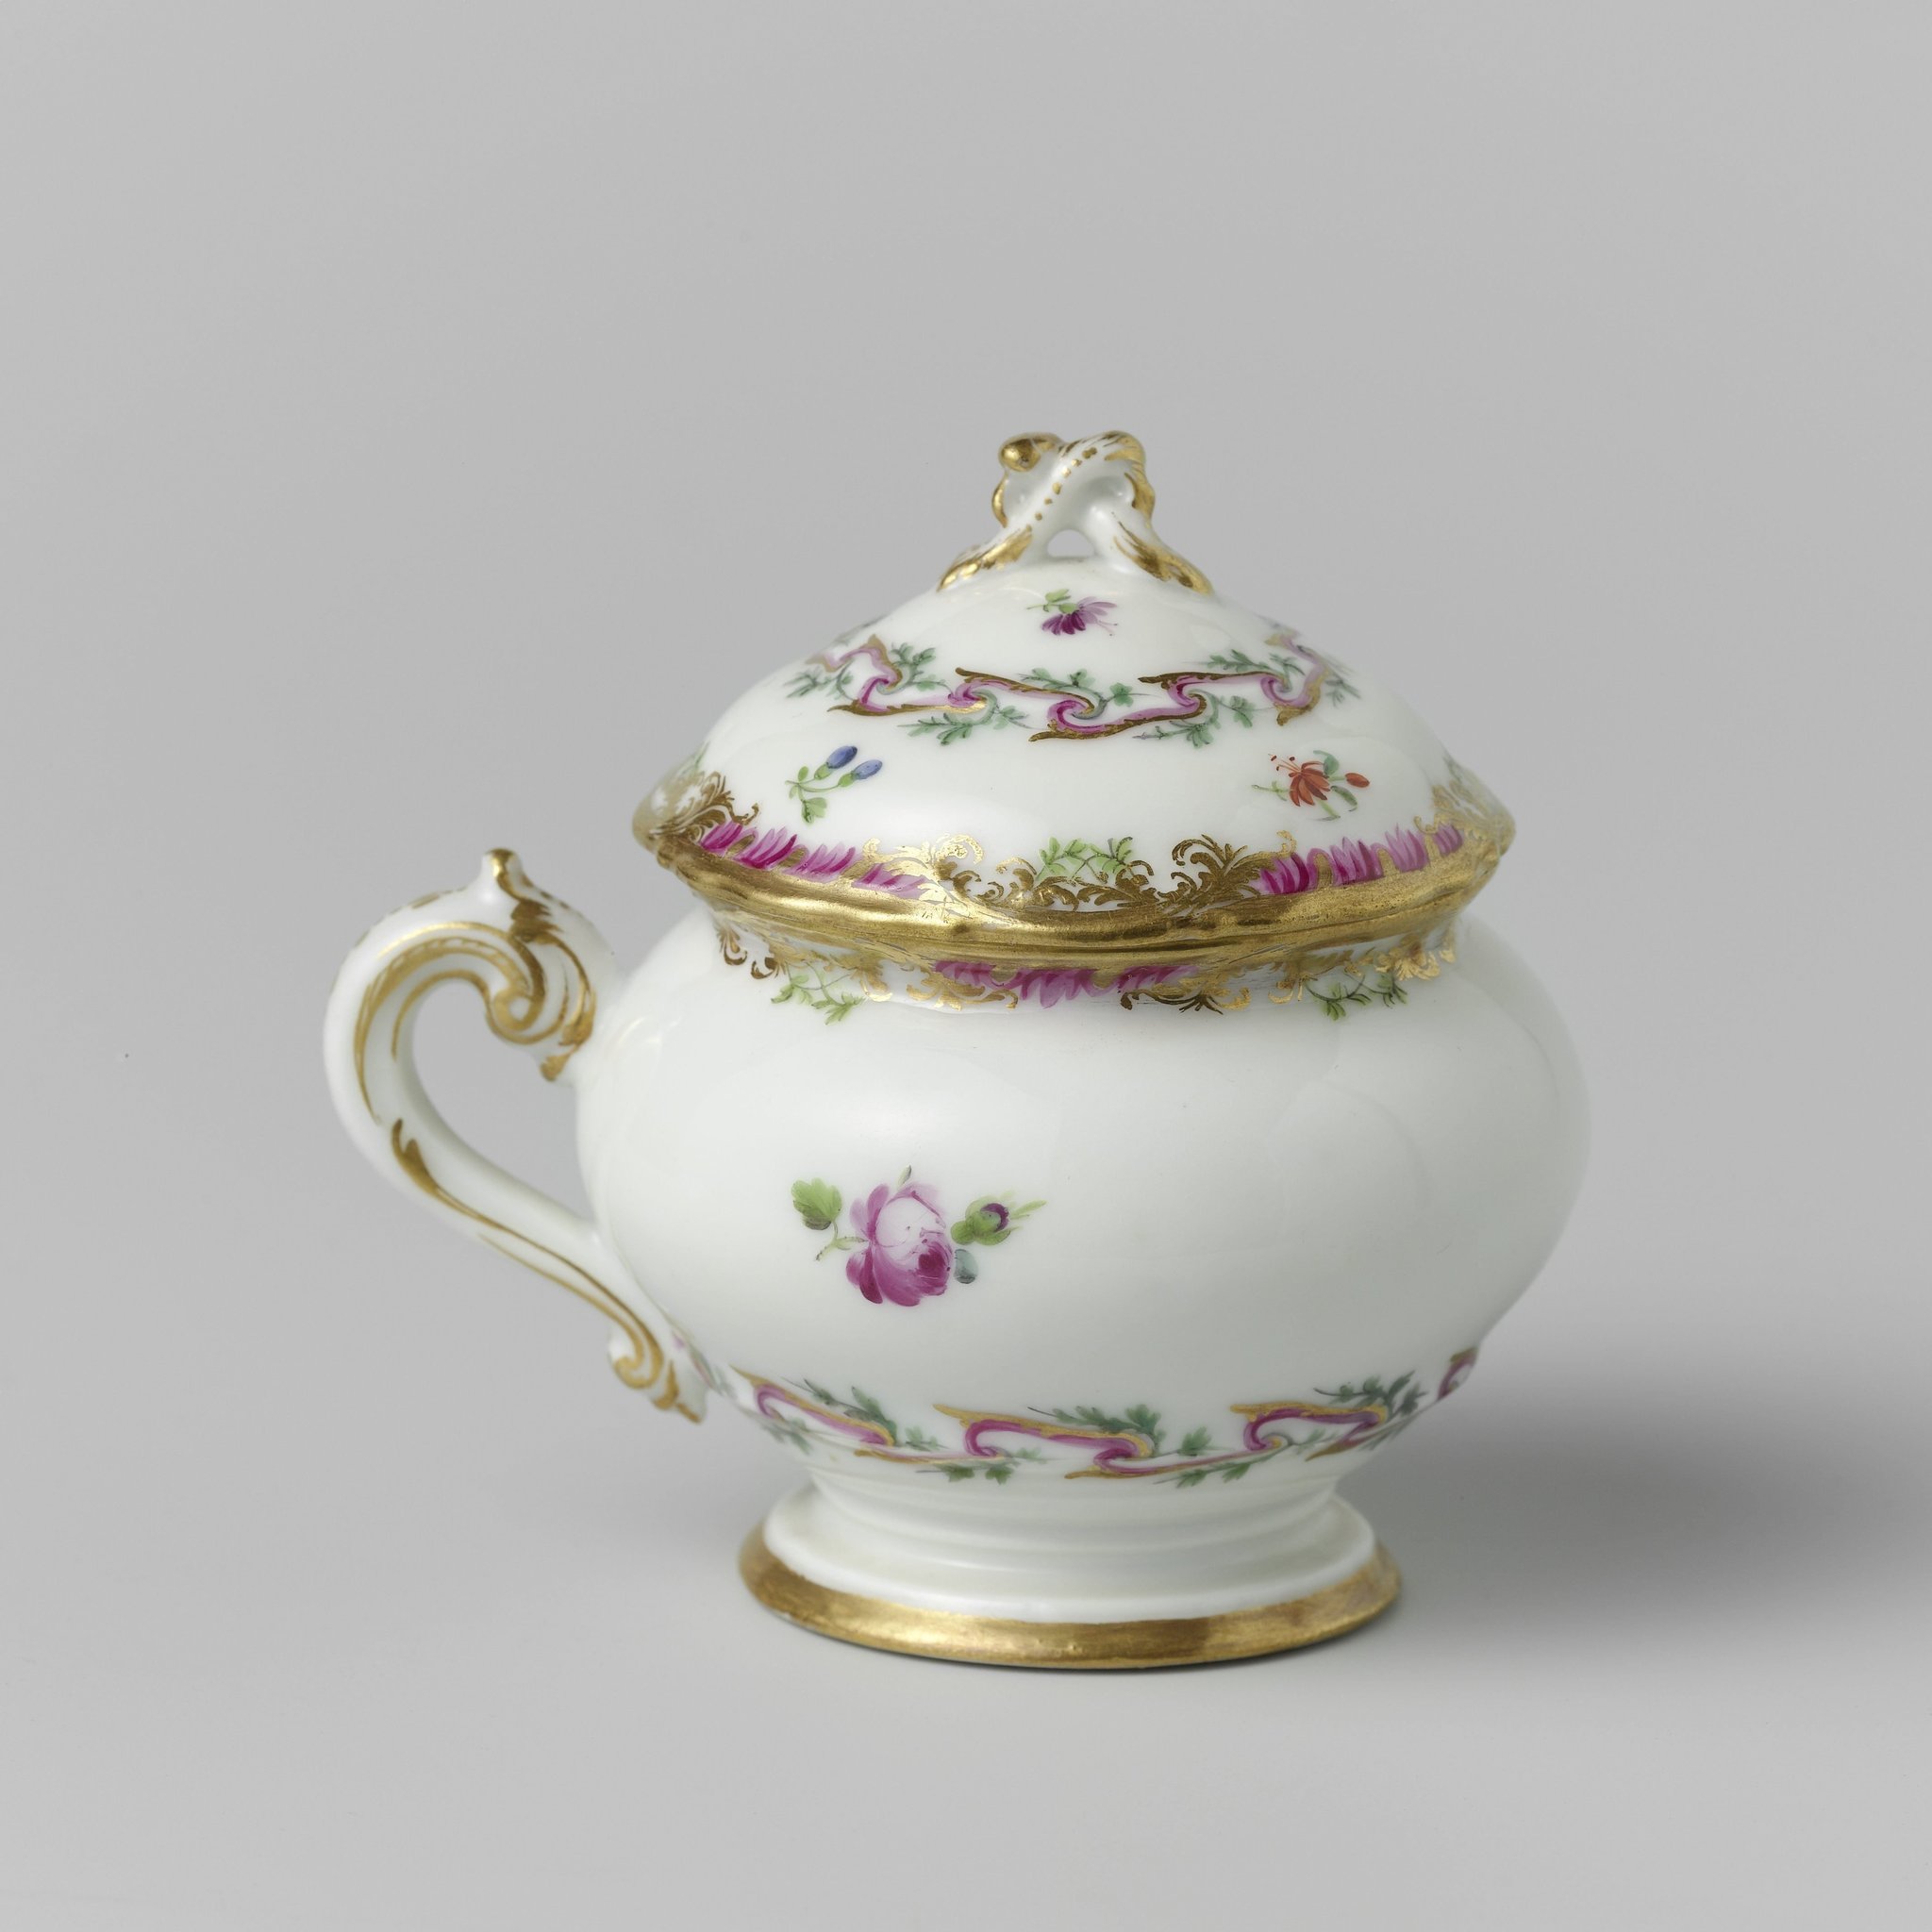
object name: pot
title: Pasteipot,rond,met deksel en oor, behorend bij een servies met geslingerd lintmotief met bladertakken, bloemboeketten en gestrooide bloemtakken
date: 1780-1820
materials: porcelain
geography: loosdrecht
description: Pasteipot, rond, met deksel en oor, behorend bij een servies van porselein met geslingerd motief in paars en goud met groene bladertakken, bloemboeketten en gestrooide bloemtakken. Randen lichtgegolfd met decoratie in goud met paars bladmotief waartussen groen gekruist bladmotief. Gemerkt: M.O.L. en AMSTEL. Serie van elf stuks.